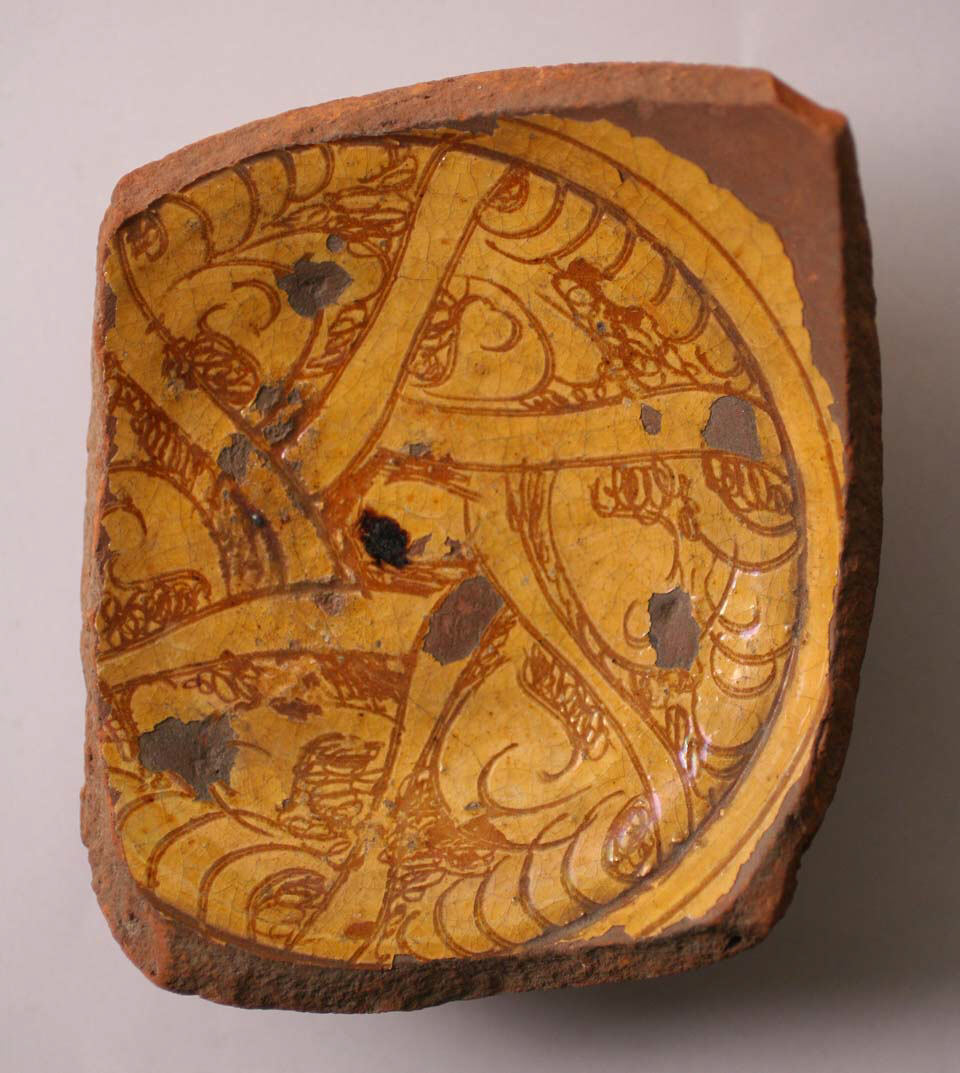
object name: ceramic fragment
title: Fragment of a Bowl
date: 1301-1500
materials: earthenware, glaze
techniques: coloring, incising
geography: egypt